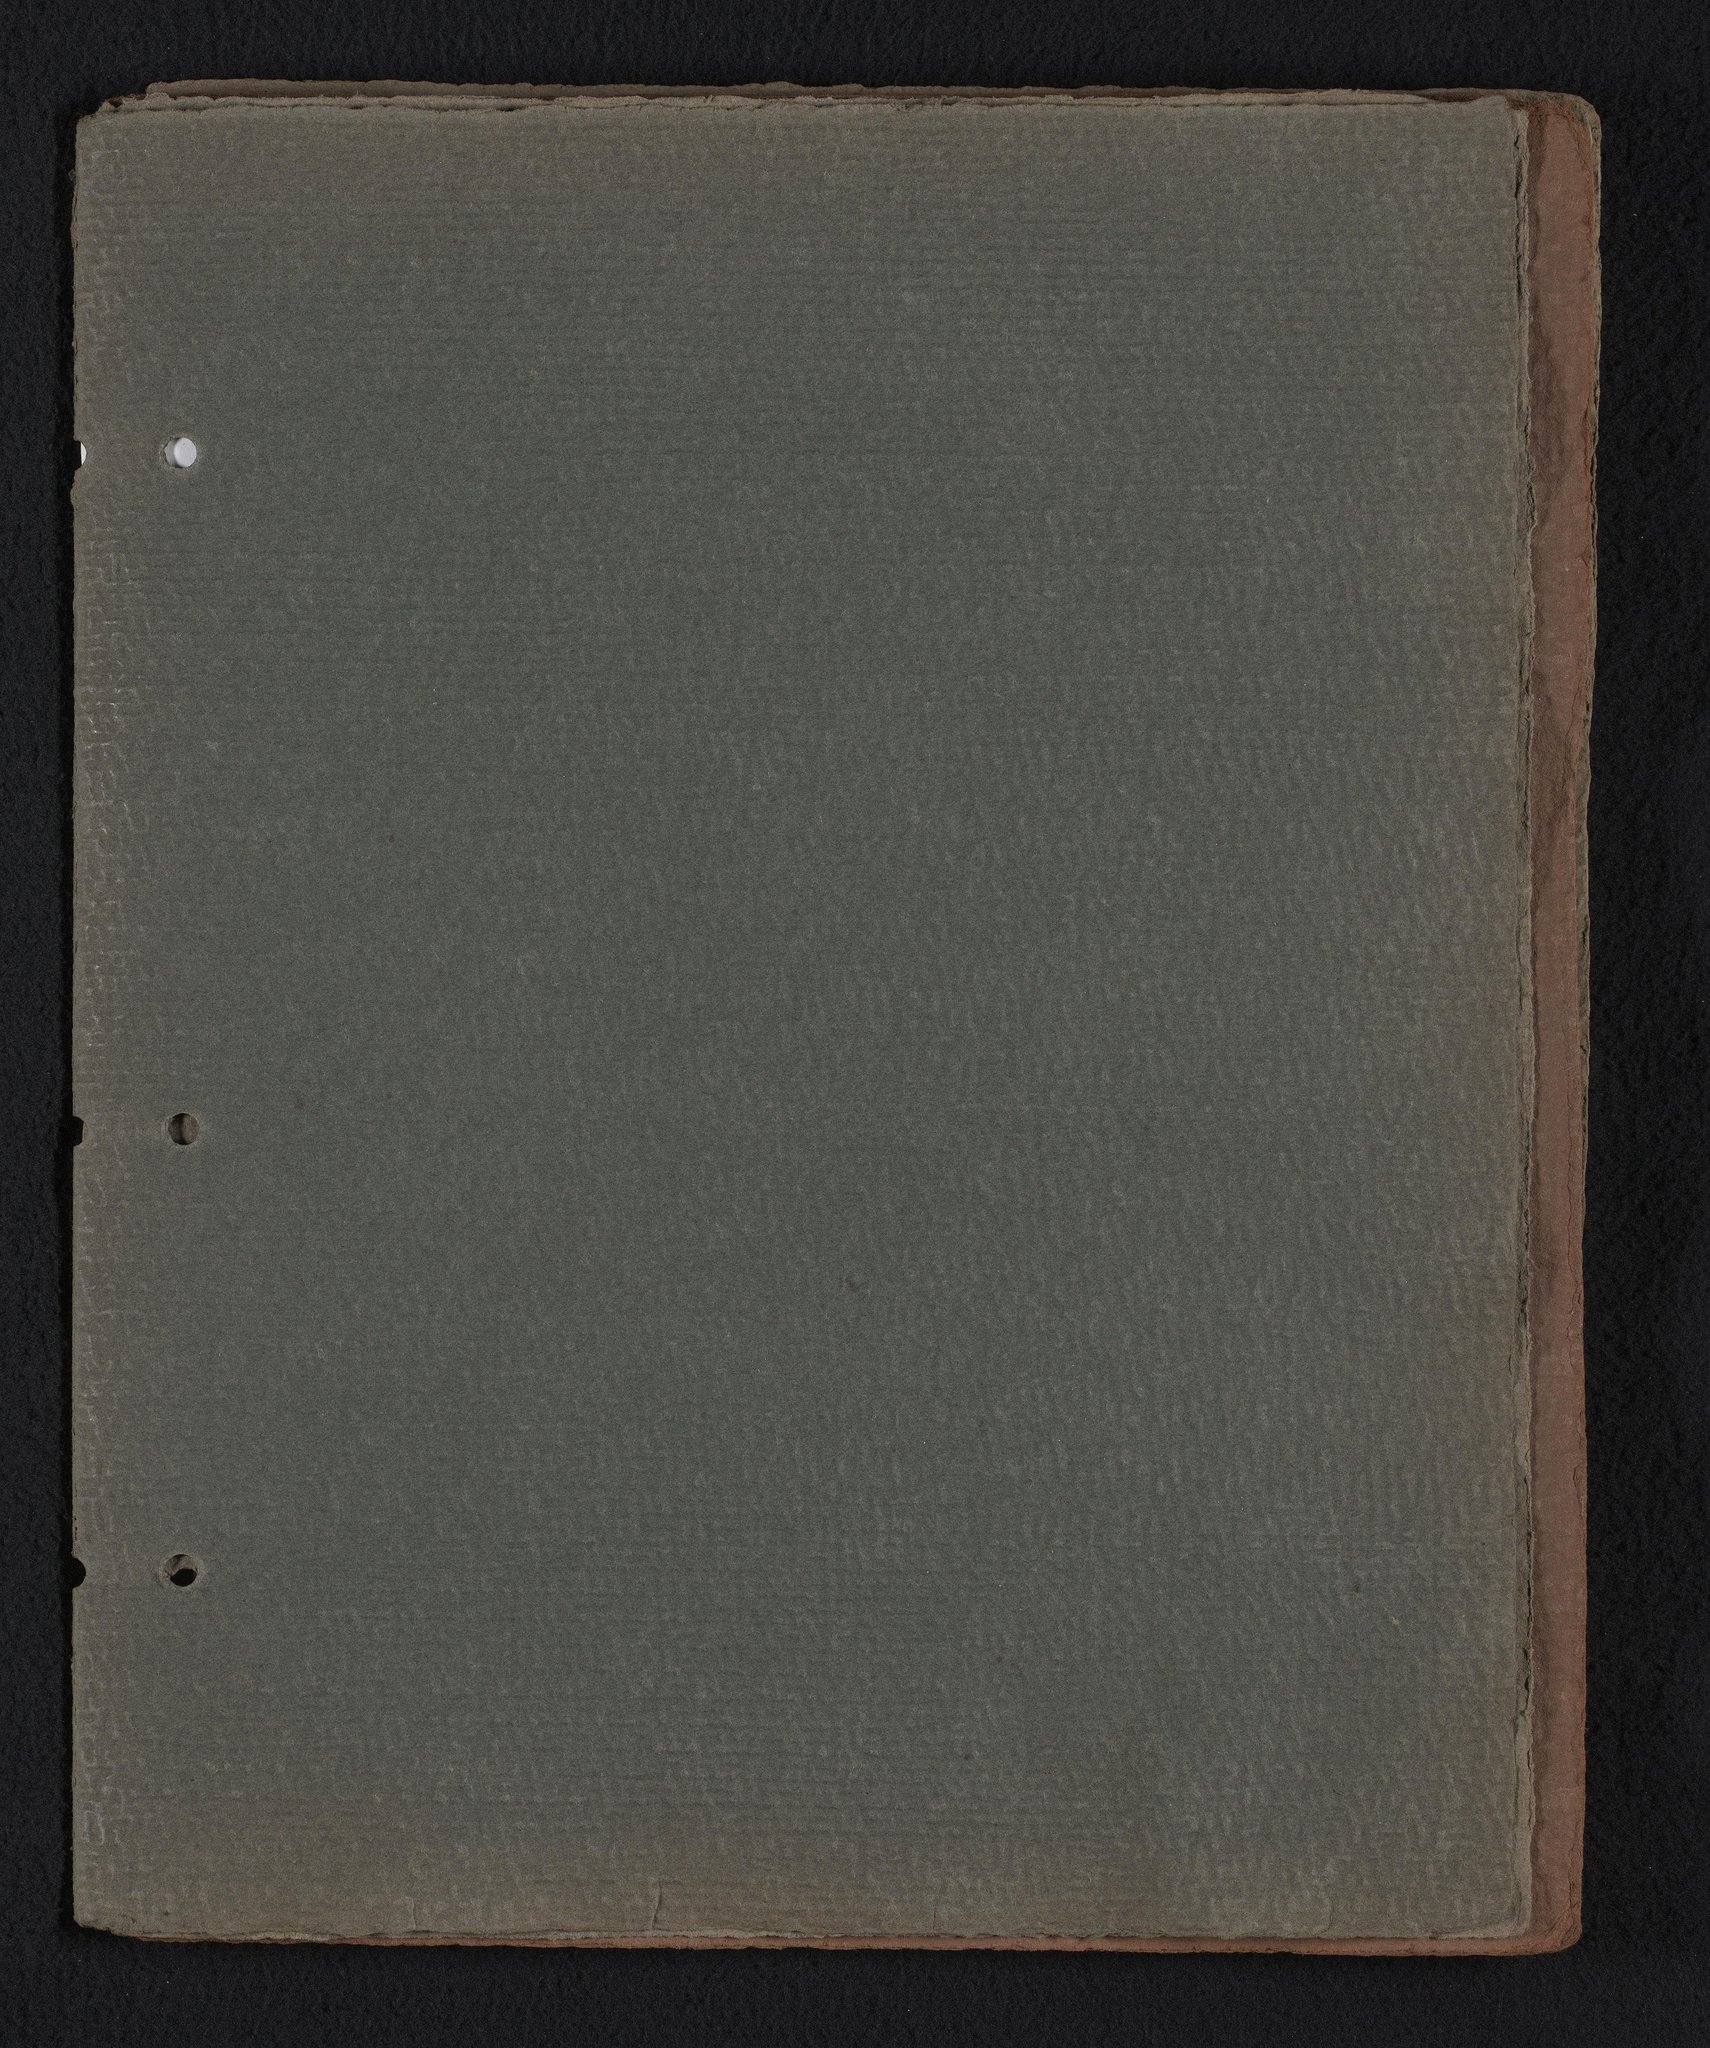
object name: wrapper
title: Omslag voor 18 bladen met 11 foto's van Caroline Louise van den Berg met Carel (Cay) en Frank van den Berg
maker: Anonymous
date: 1900-1920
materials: cardboard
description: Pagina's 1, 10, 11, 12, 17 en 18 bevatten geen foto's.